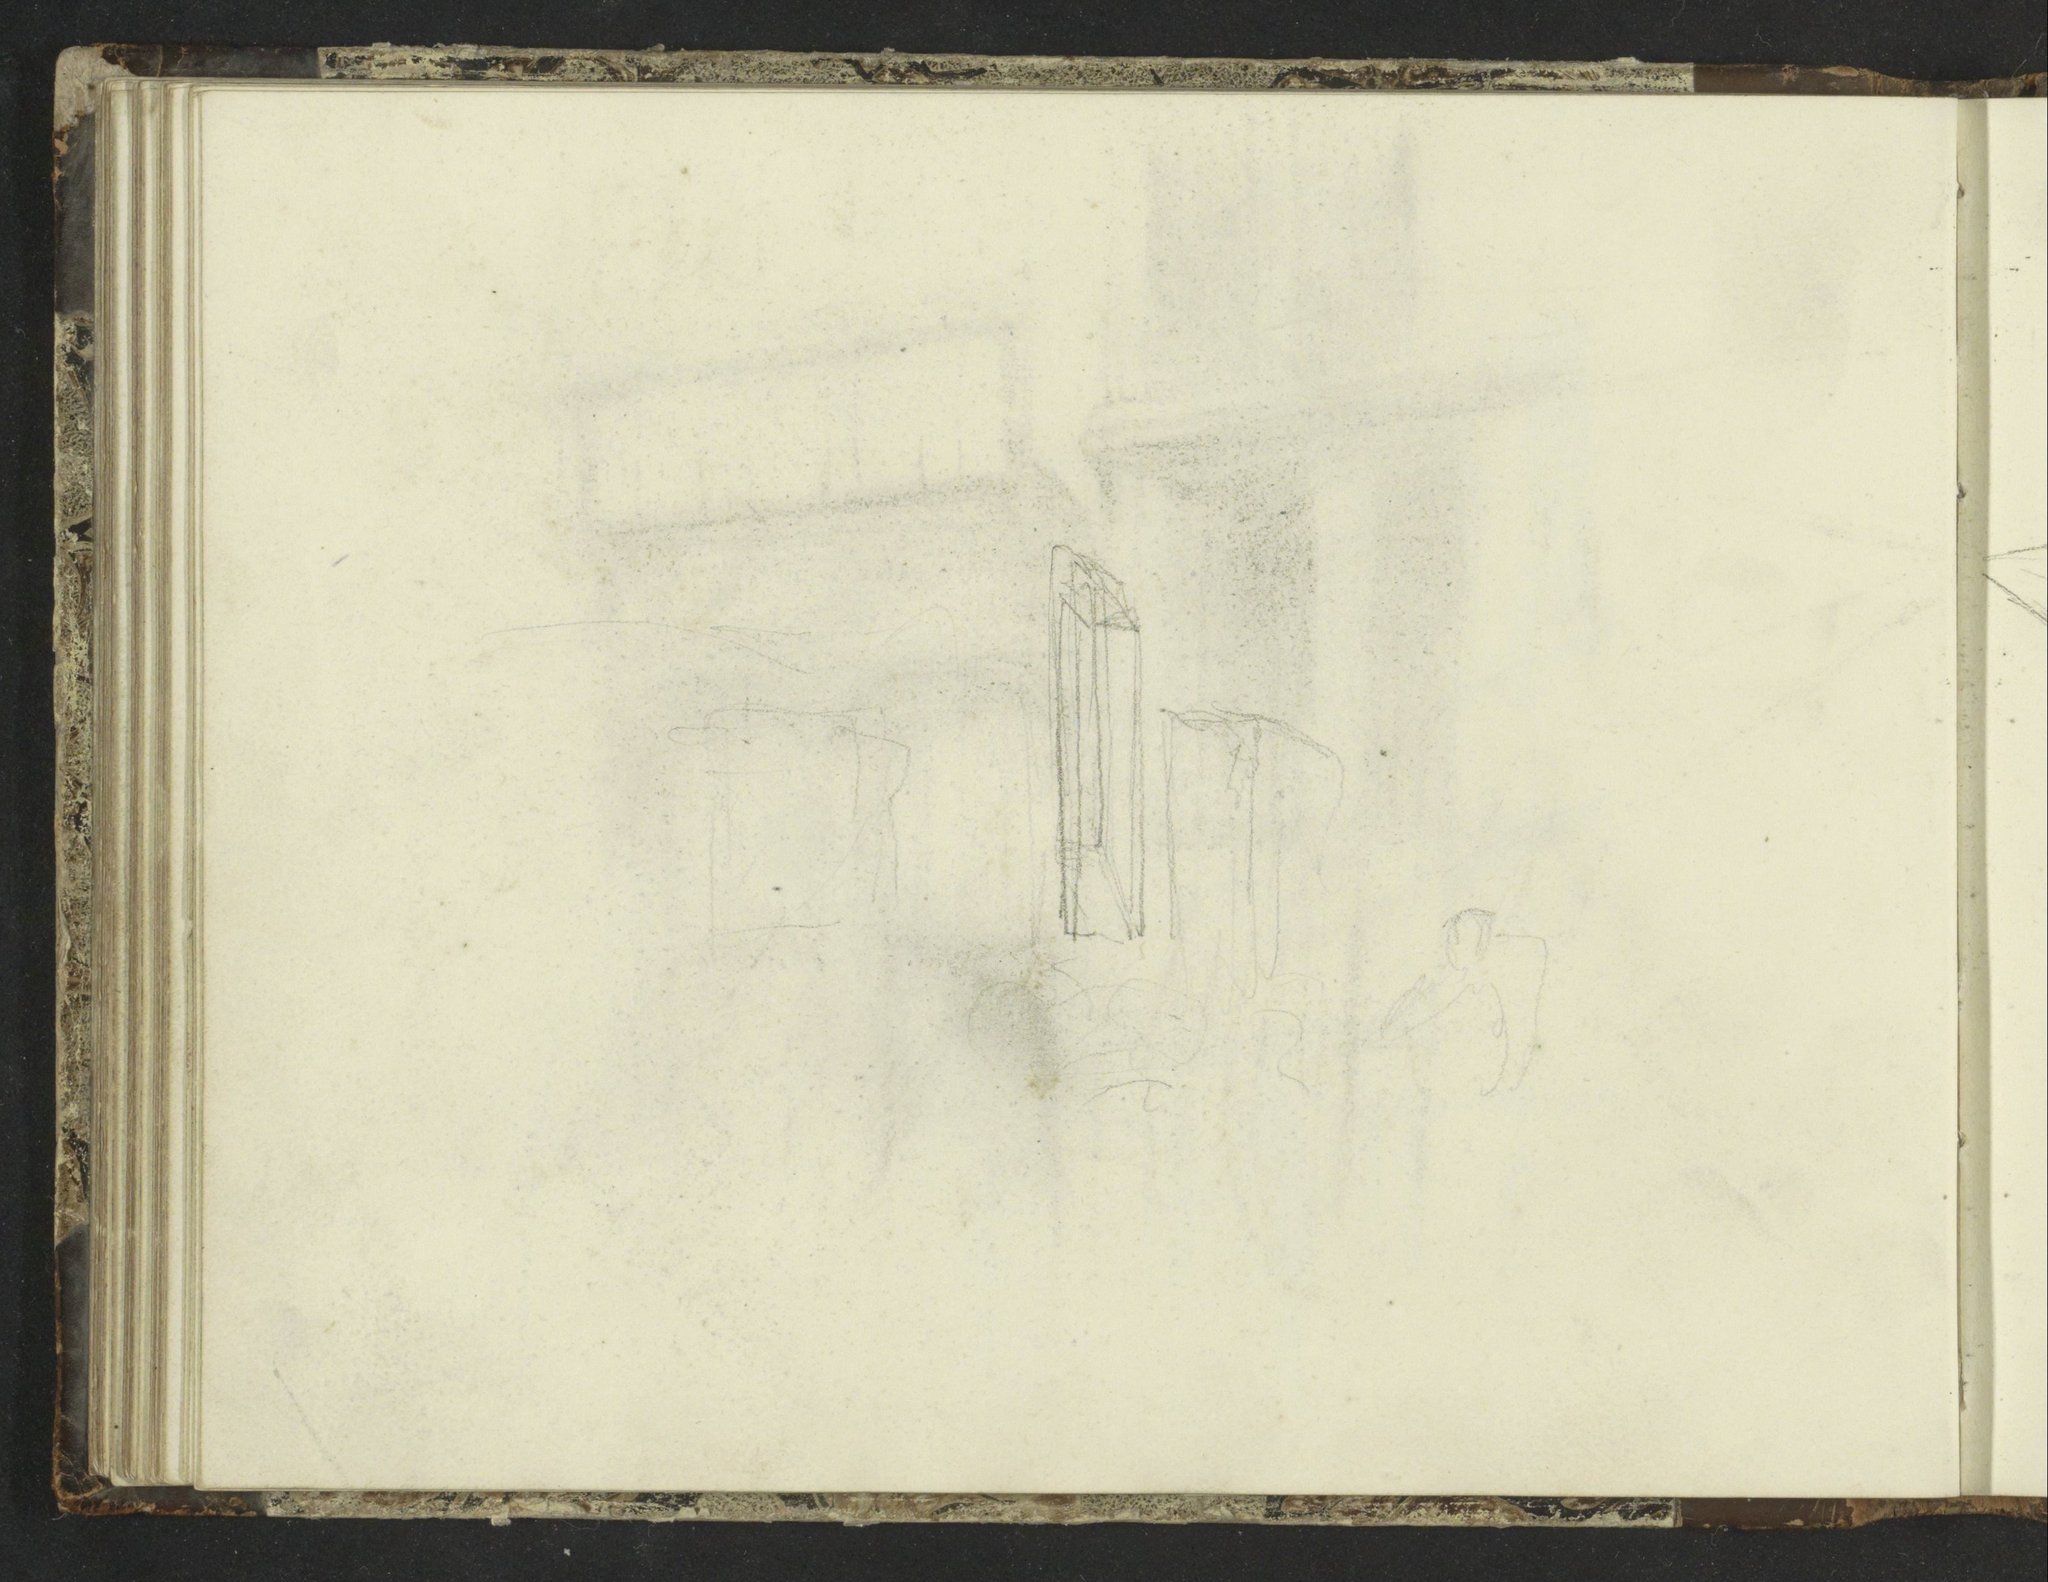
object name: sketchbook leaf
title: Gevel met vensters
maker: willem hendrik schmidt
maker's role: draughtsman, painter, print maker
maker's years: 1809-1849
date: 1819-1849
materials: paper, pencil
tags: window, front façade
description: Tevens een studie van een figuur. Blad 26 verso uit een schetsboek met 58 bladen.